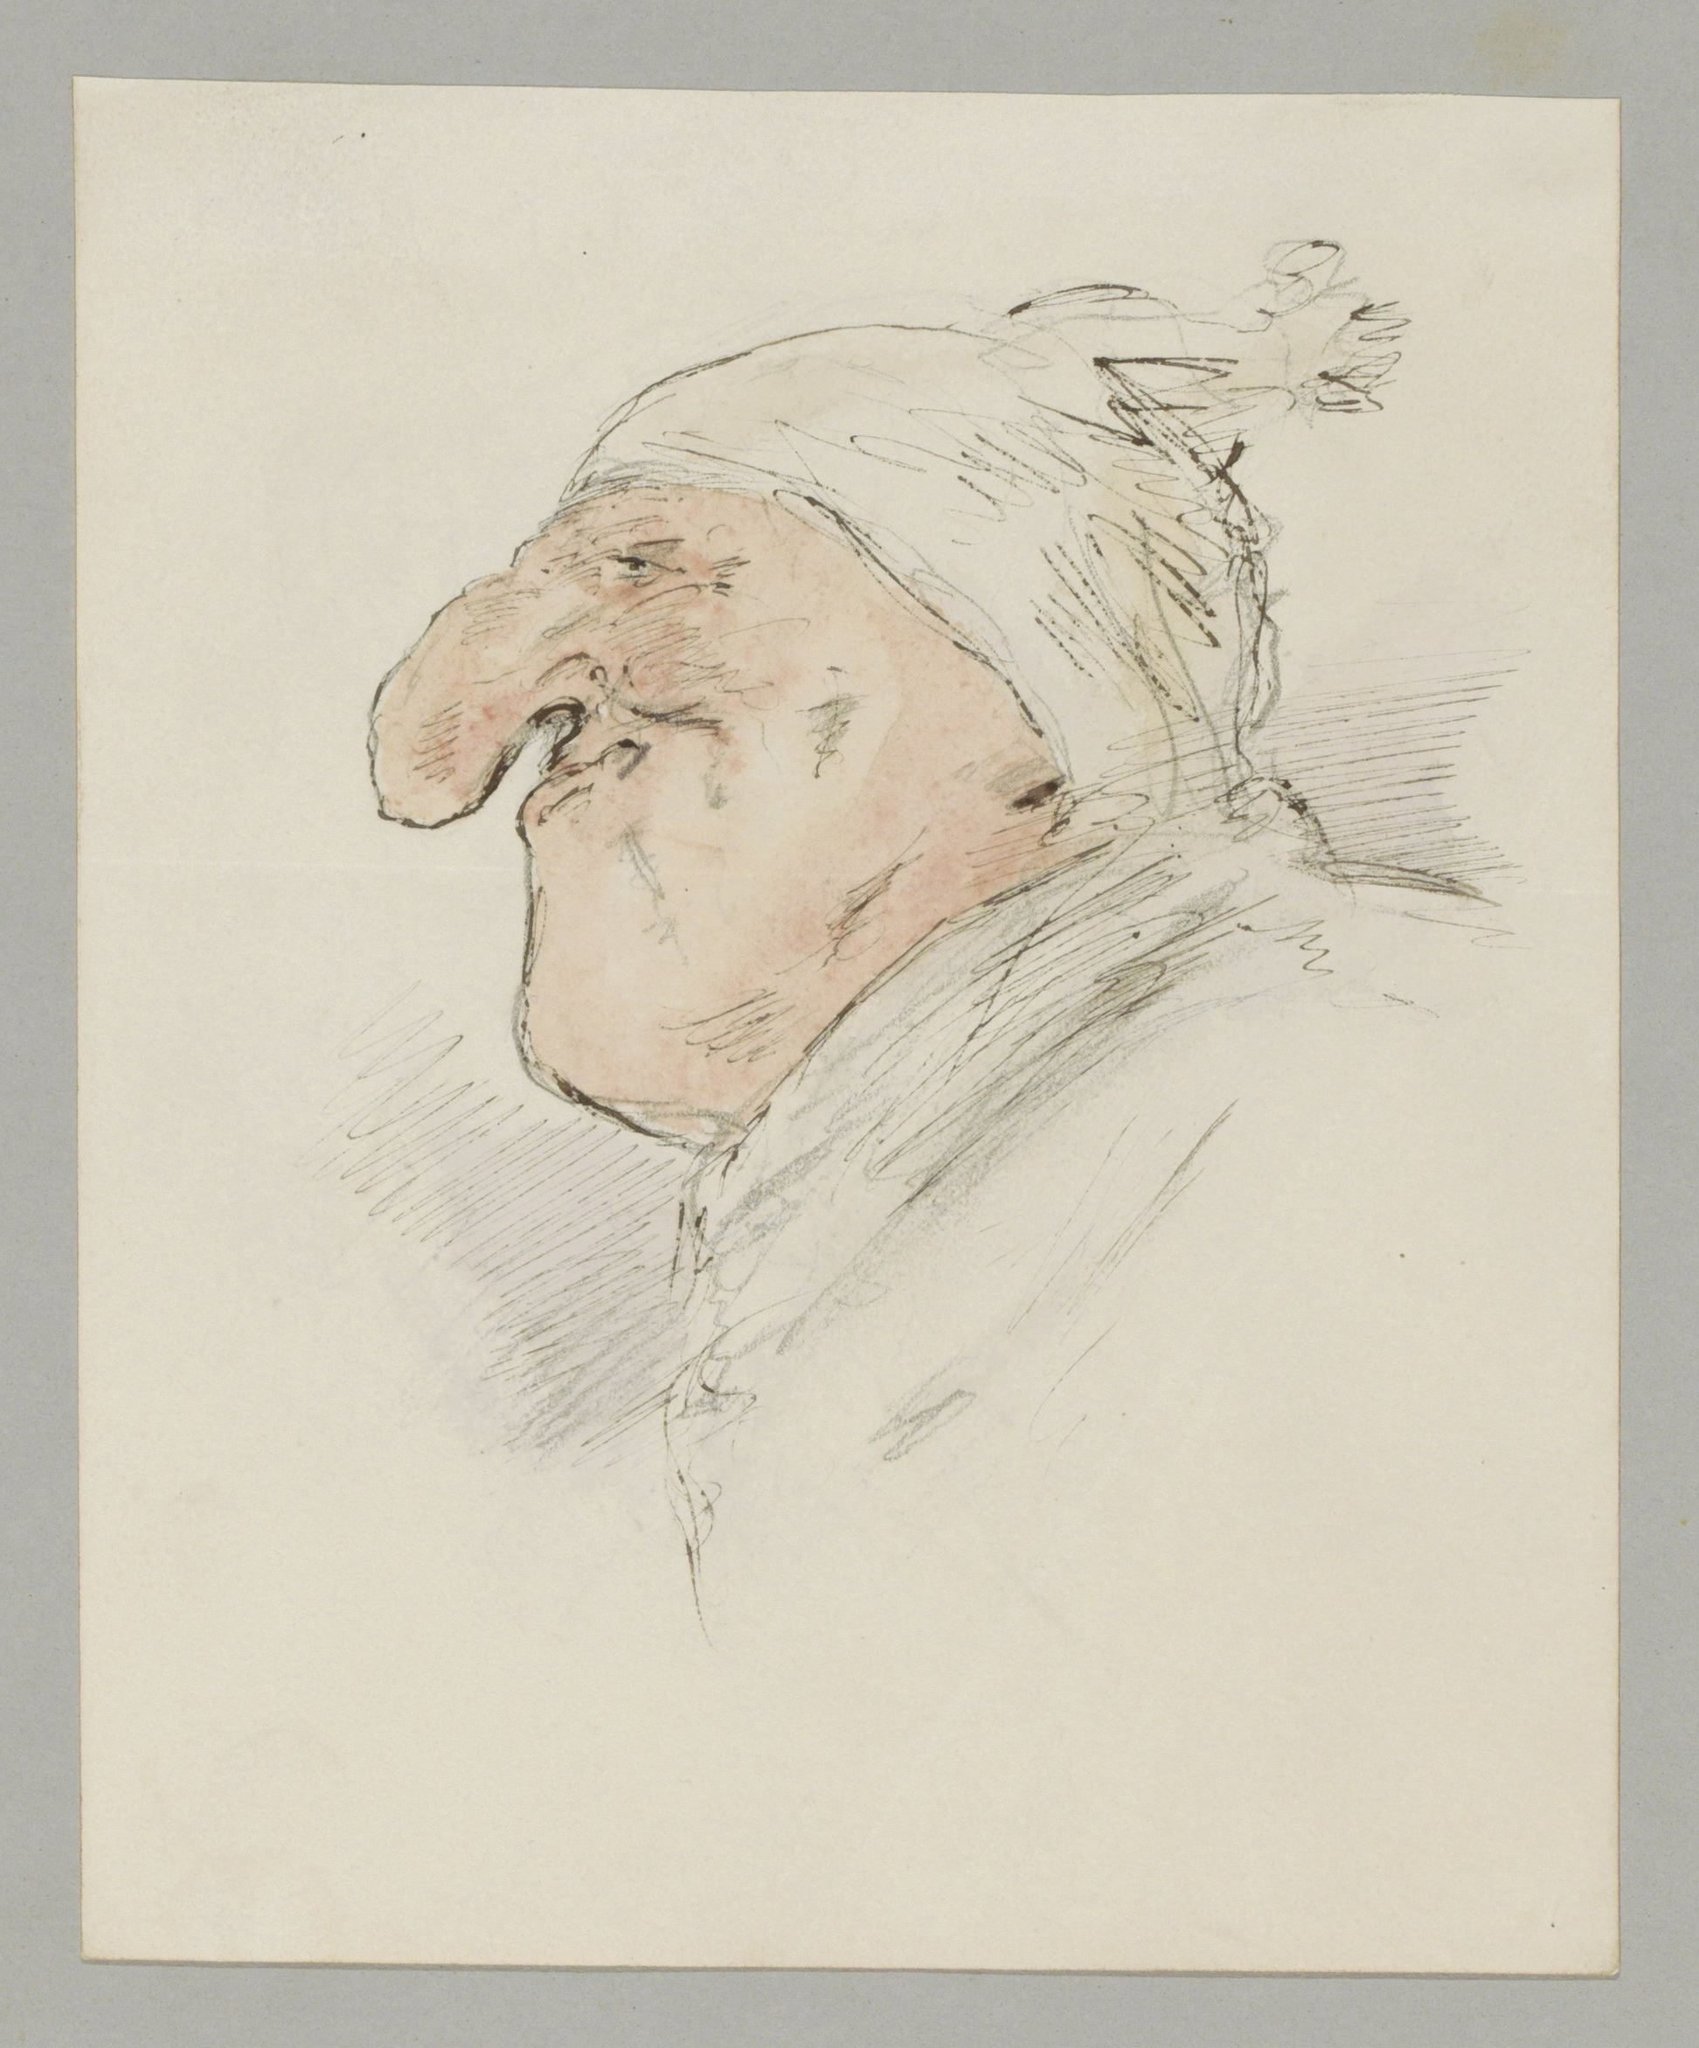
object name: album leaf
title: Karikaturale kop van een man met een slaapmuts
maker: alexander ver huell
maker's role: draughtsman, print maker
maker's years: 1822-1897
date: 1854-1887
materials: ink, paper, pencil, watercolor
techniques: brush, pen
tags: caricatures (human types), nightwear: night-cap (+ men's clothes)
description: Recto van tekening 2 op blad 21 van een album met 35 tekeningen.